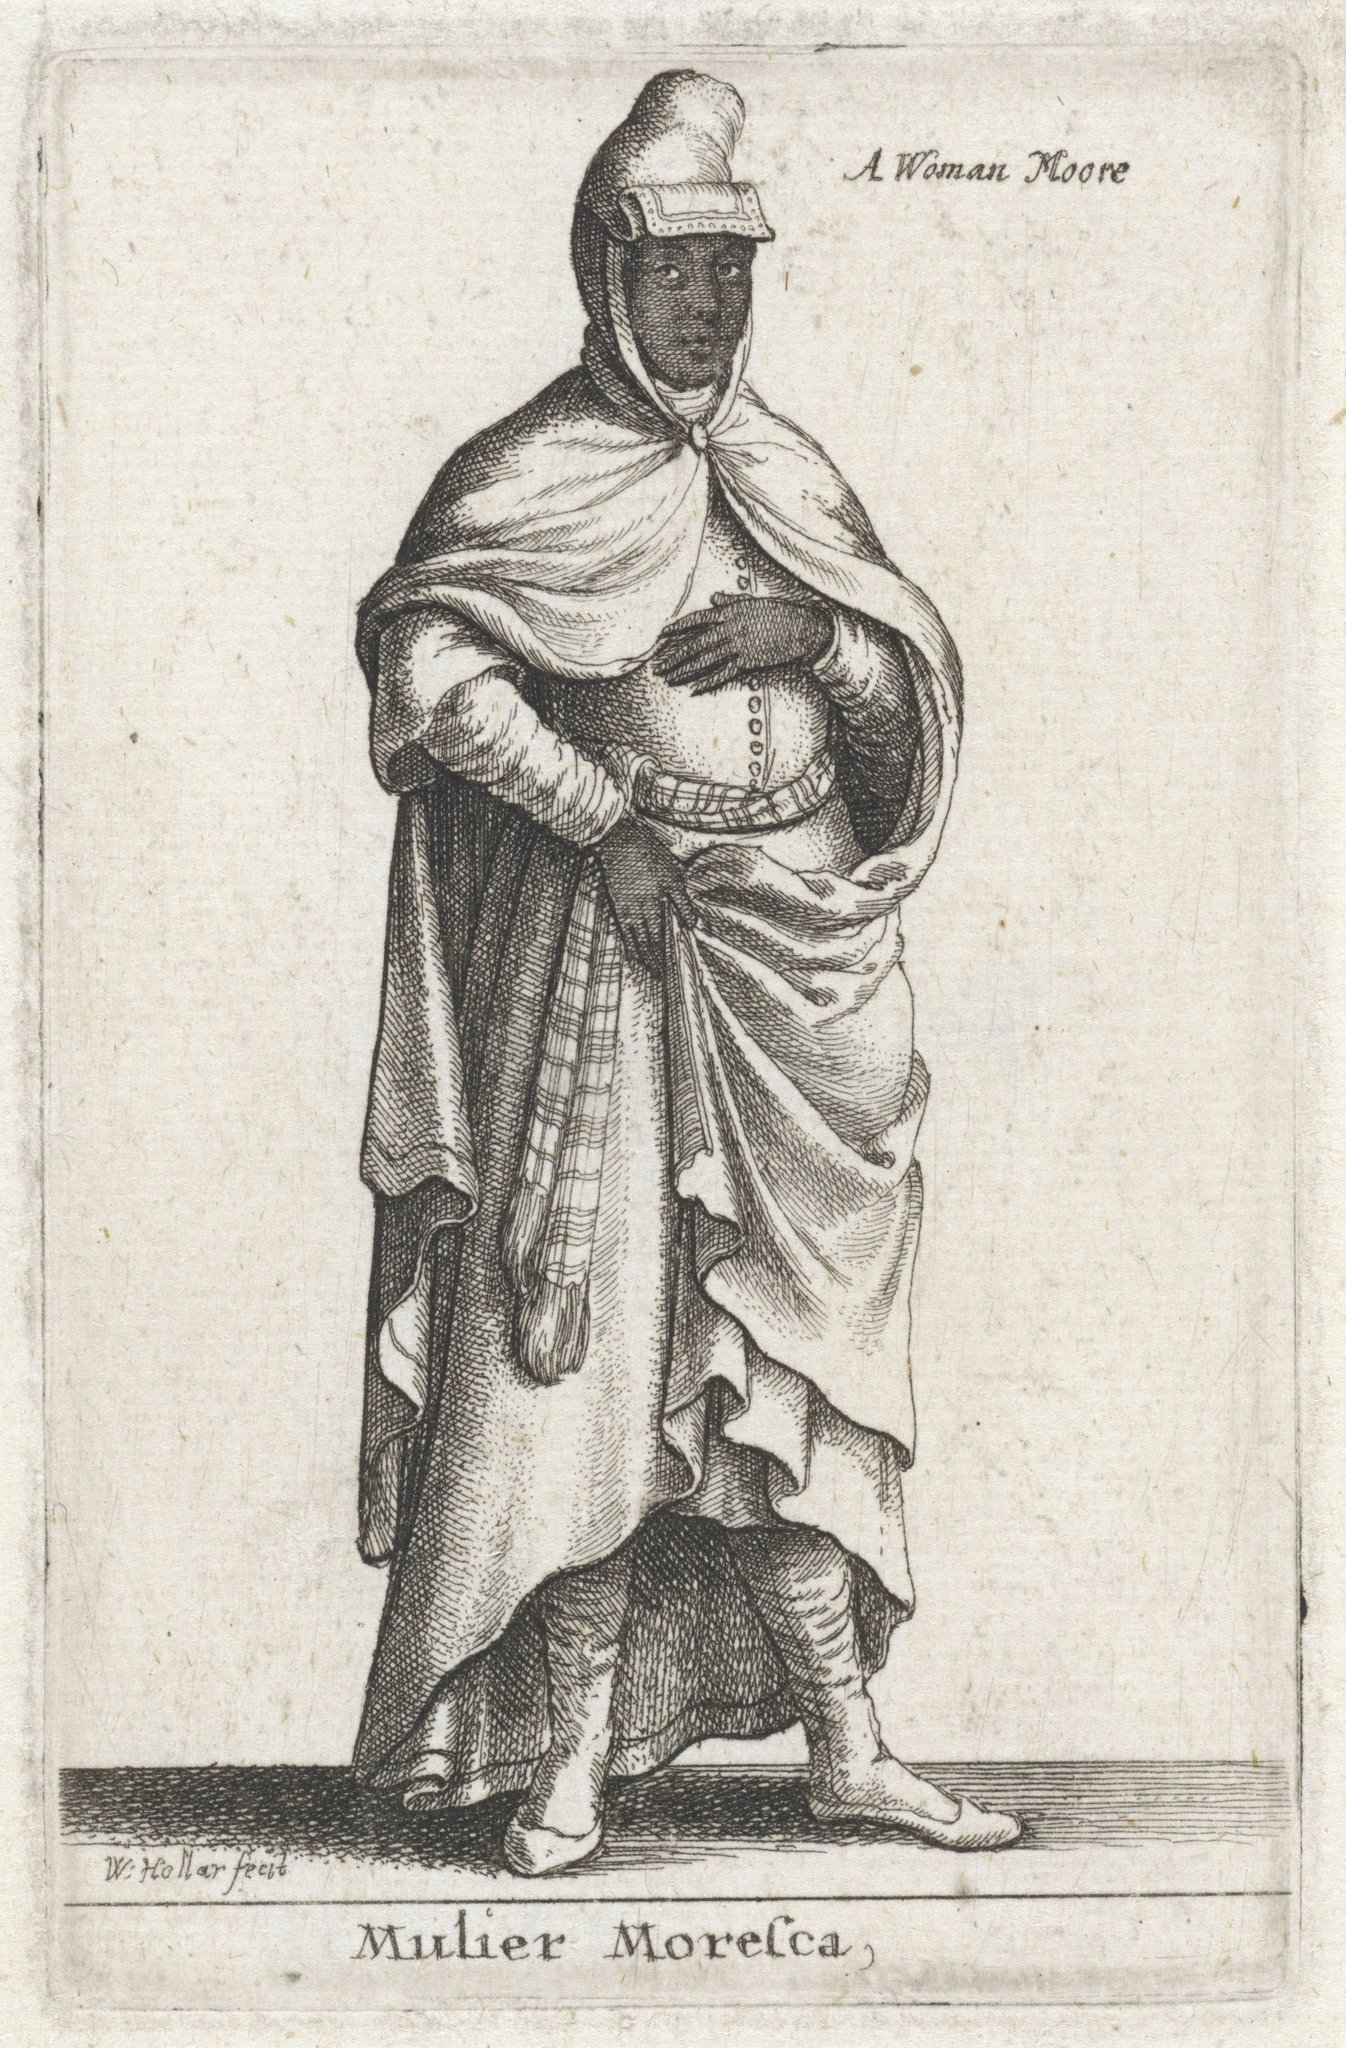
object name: costume print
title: Mulier Moresca / a Woman Moore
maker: wenceslaus hollar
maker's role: draughtsman, print maker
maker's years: 1607-1677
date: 1644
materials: paper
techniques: etching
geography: london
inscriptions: collector's mark: Lugt 240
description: De prent maakt deel uit van de twaalfdelige serie met klederdracht van vrouwen uit verschillende landen.